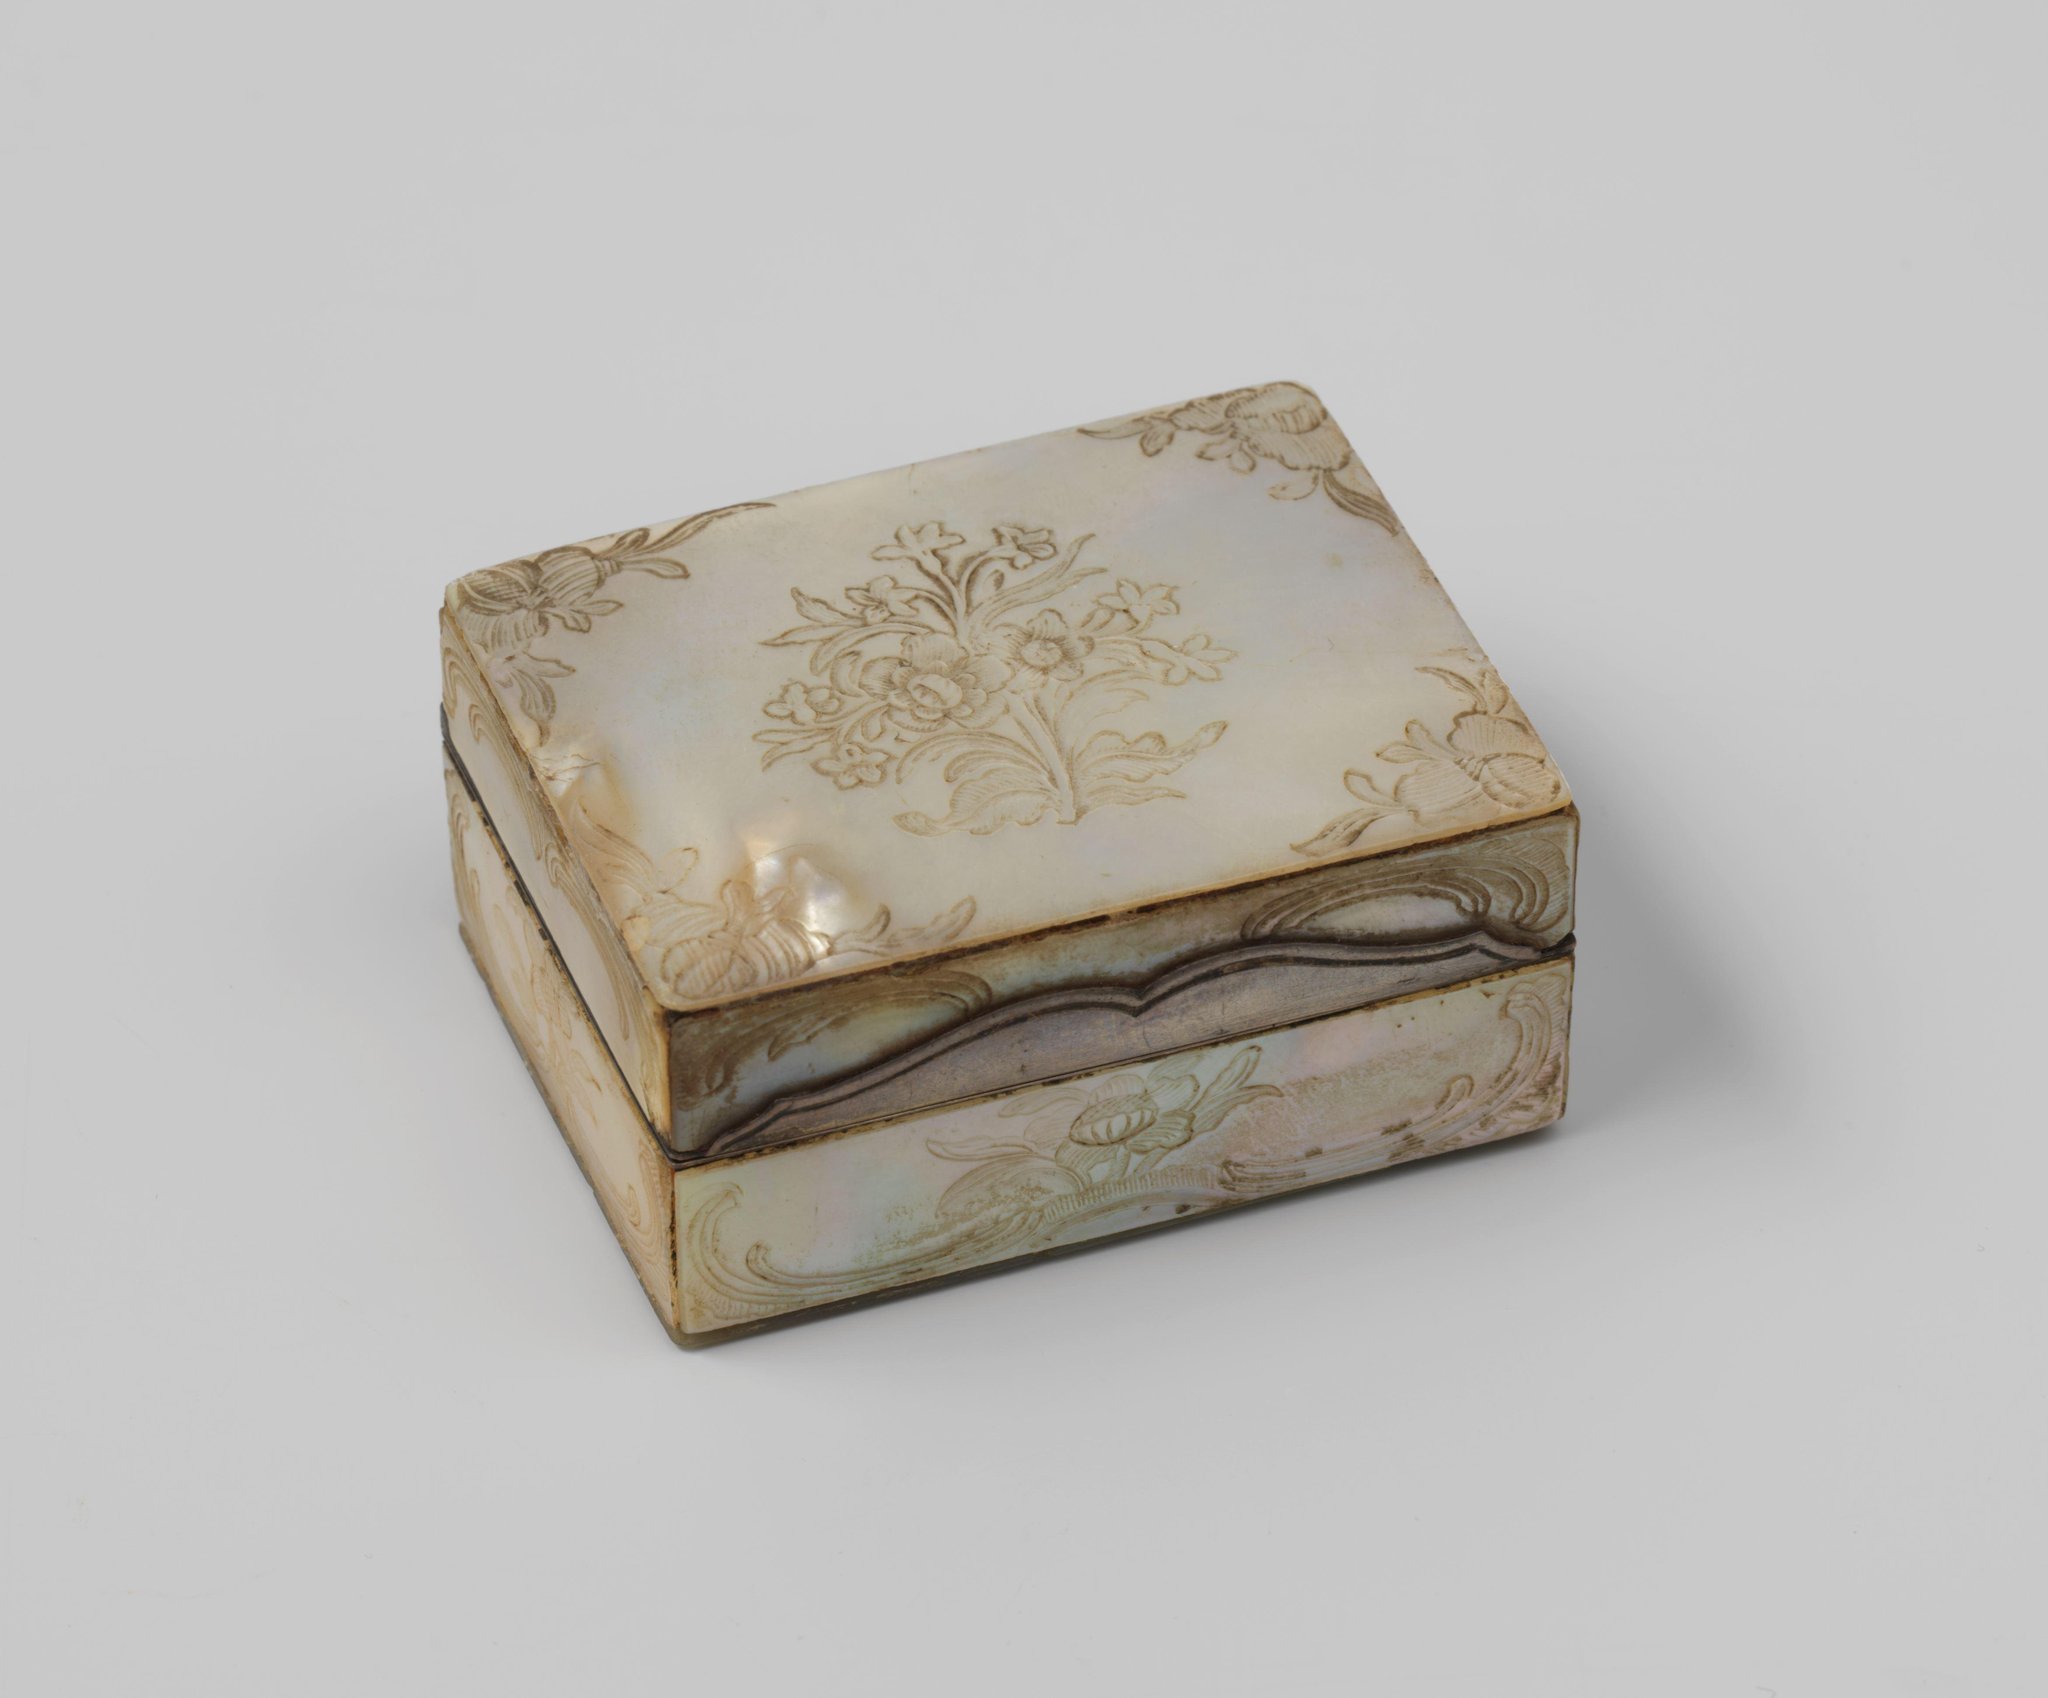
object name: box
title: Schminkdoos, rechthoekig, bekleed met parelmoer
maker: Anonymous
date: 1750-1770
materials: mother of pearl, silver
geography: paris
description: Een schminkdoos van buiten met parelmoer en van binnen met zilver bekleed. In het parelmoer zijn bloemen en bladeren gegraveerd. In de binnenkant bevinden zich in twee gesloten vakken met parelmoeren deksels een zilveren lepel en een spiegel.